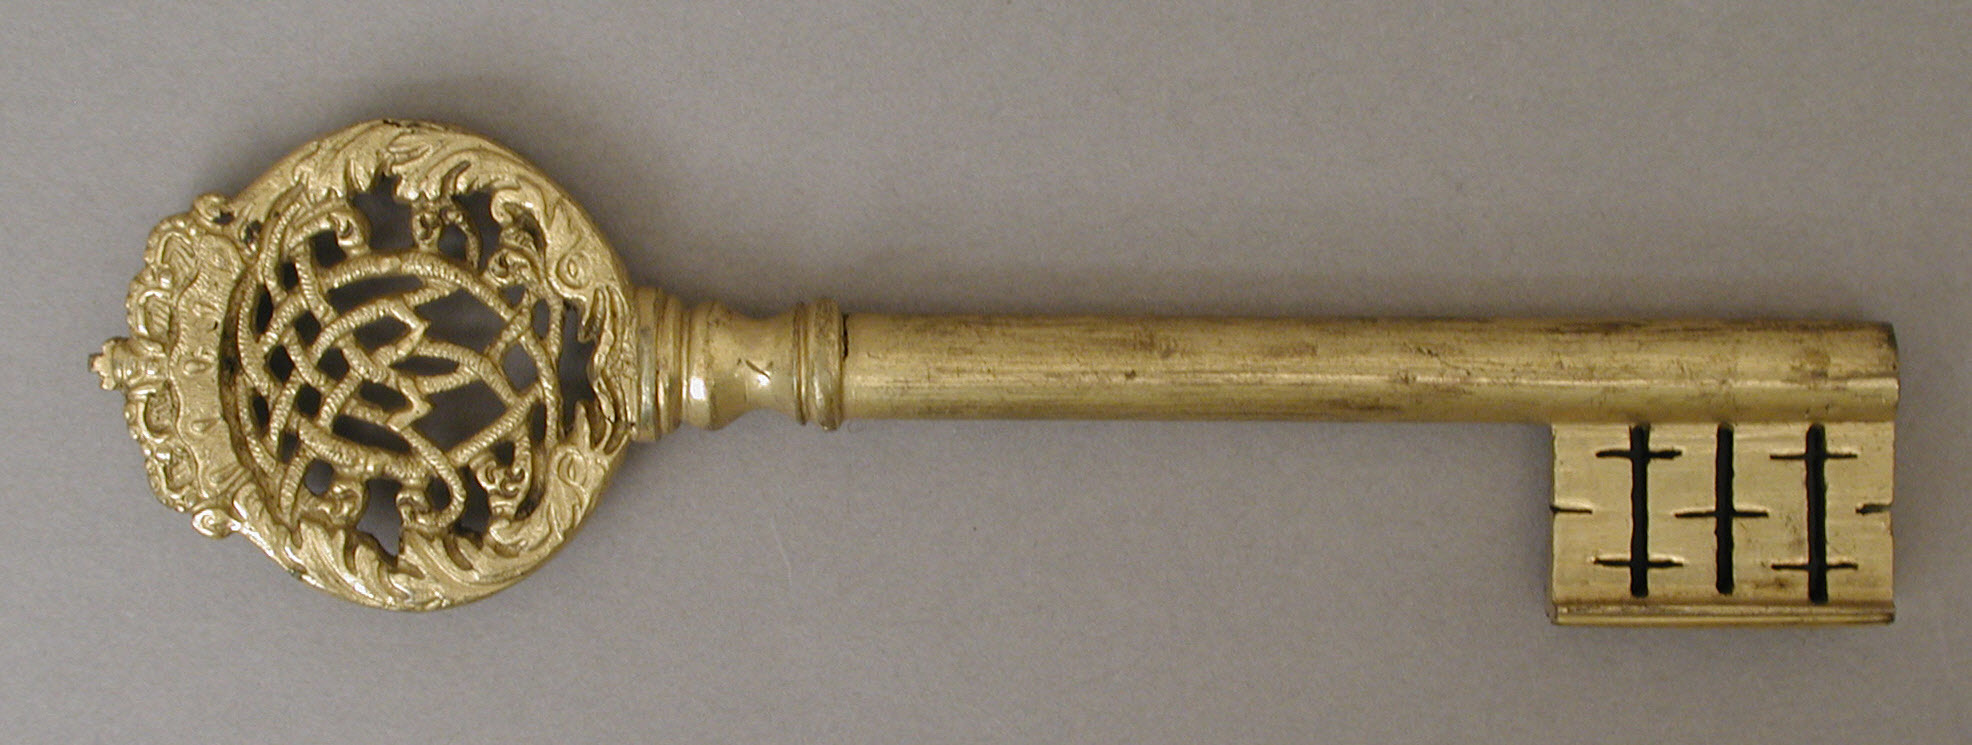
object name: key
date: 1701-1800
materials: gilt, iron